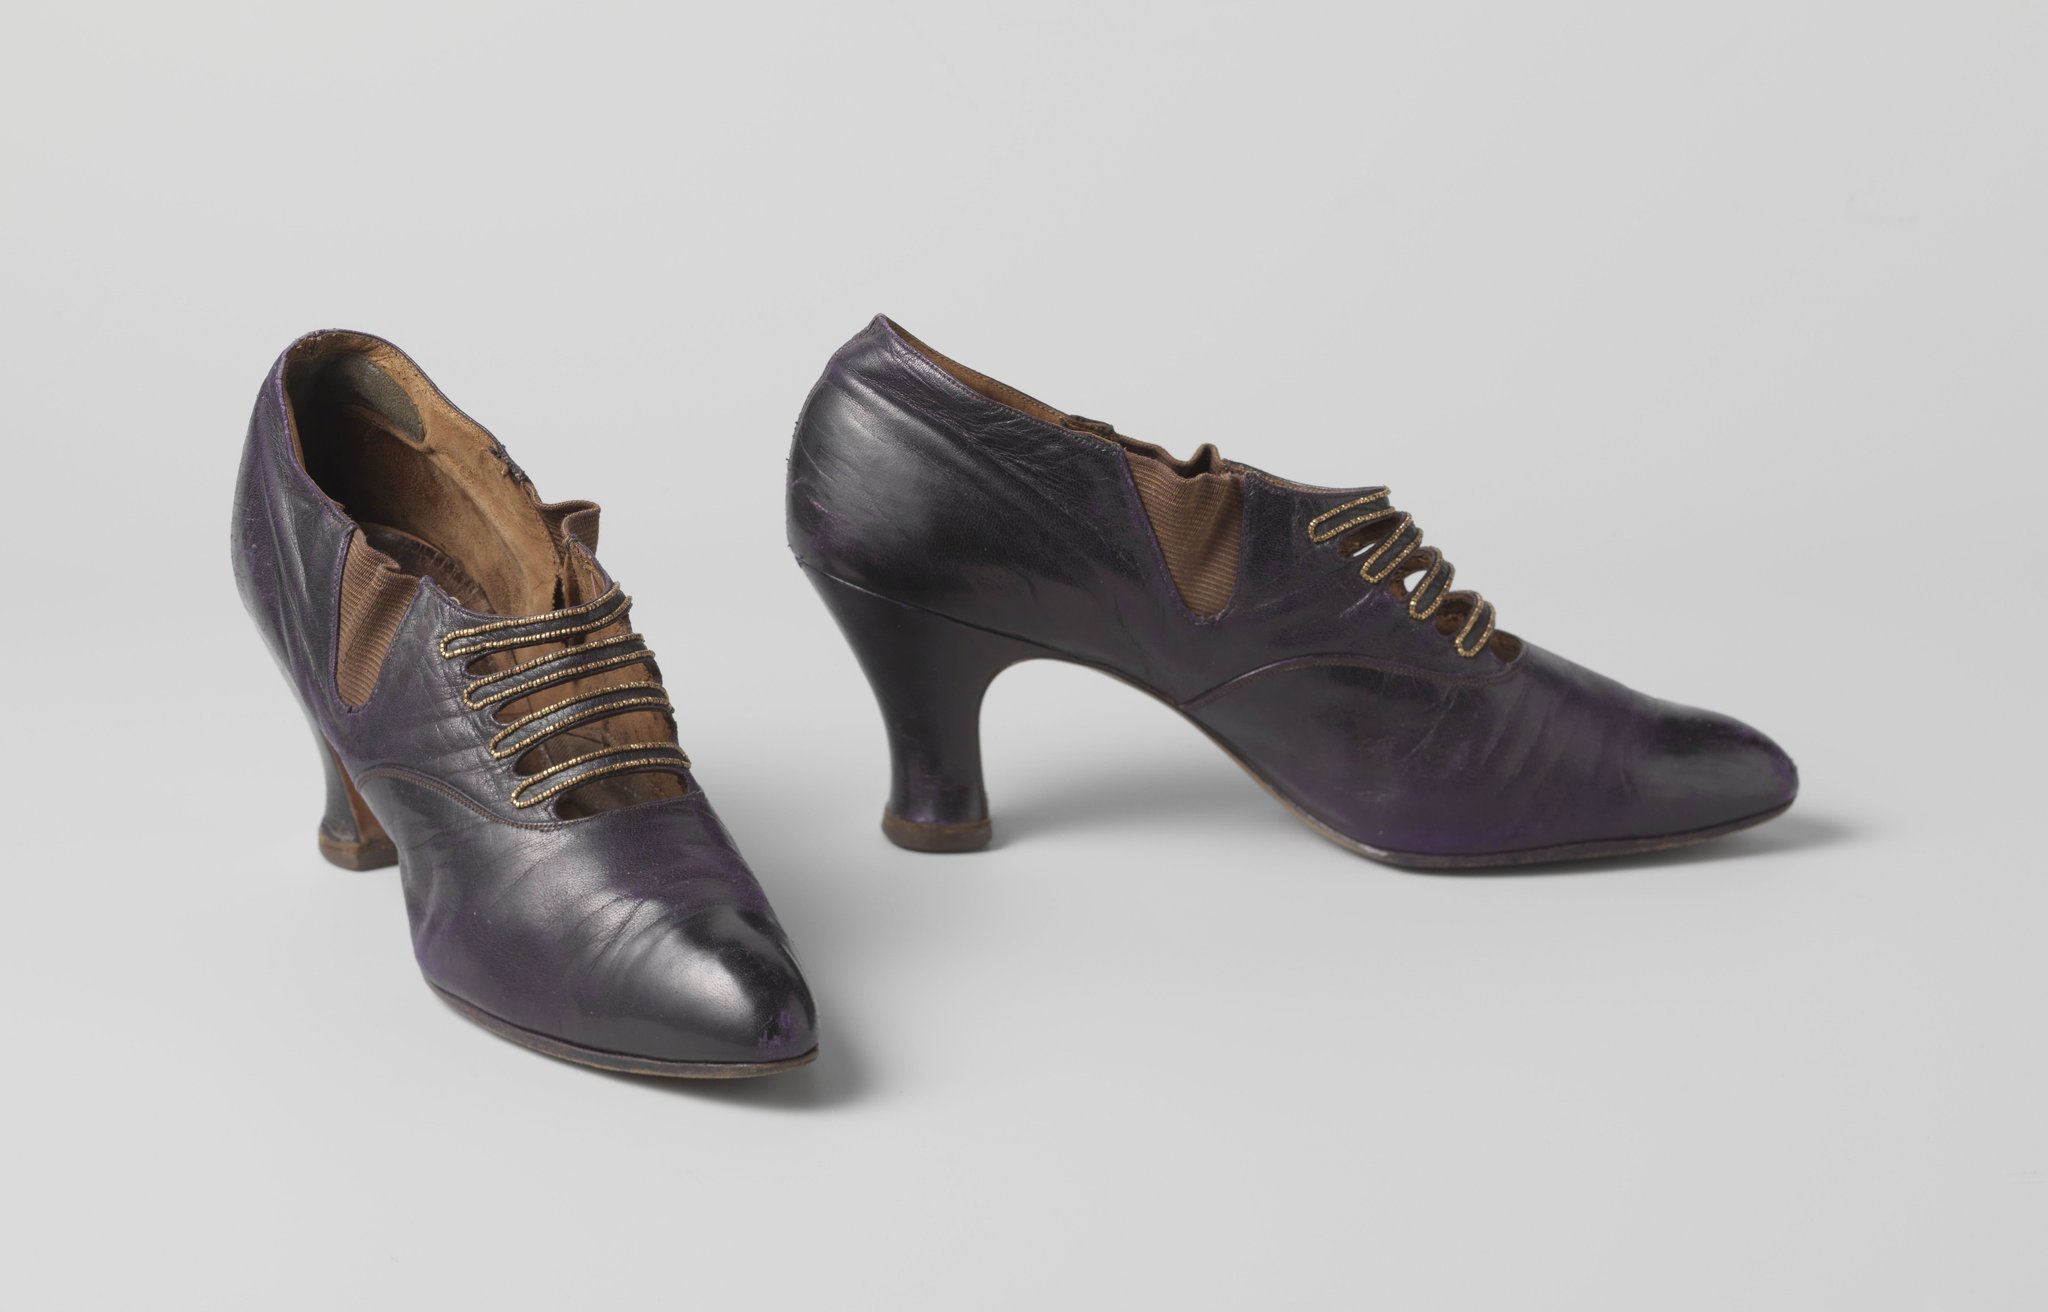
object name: womenswear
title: Bandschoen van goudtorrenleer met vier bandjes over de wreef versierd met een reeks goudkleurige geslepen metalen kralen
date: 1910-1915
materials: cotton, leather, metal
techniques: grinding, painting, tanning, weave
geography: netherlands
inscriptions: factory mark: ‘Bally // importé de suisse’, size: ‘7- // 4’, inscription: ‘7- 484873 // 8’, company name: ‘Cordonnerie Suisse // Smith v/h Paanakker // AMSTERDAM•HAAG•ROTTERDAM’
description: Damesschoen van goudtorrenleer met vier bandjes over de wreef. Model: Afgeronde spitse neus, één voorblad en twee zijbladen. Hoge schacht tot net onder de enkel. Boven de uitsnijding van het voorblad van de voorvoet vier horizontale bandjes over de wreef. Halverwege de zijbladen aan beide kanten een stuk bruin elastiek. De voorkant van de hak loopt in een afgeronde hoek recht naar beneden. De zijkant en achterkant van de hak zijn getailleerd en bekleed met goudtorrenleer. Leren achterlapje met vijf spijkers aan de hak vastgeslagen en leren zool. Zijbladen gevoerd met bruin leer. Voorblad gevoerd met mosgroen geribd katoen. De hiel is verstevigd met een stuk mosgroen geruwd leer. De binnenzool is van bruin leer. Versiering: De vier bandjes over de wreef zijn langs de randen versierd met een reeks goudkleurige geslepen metalen kralen.